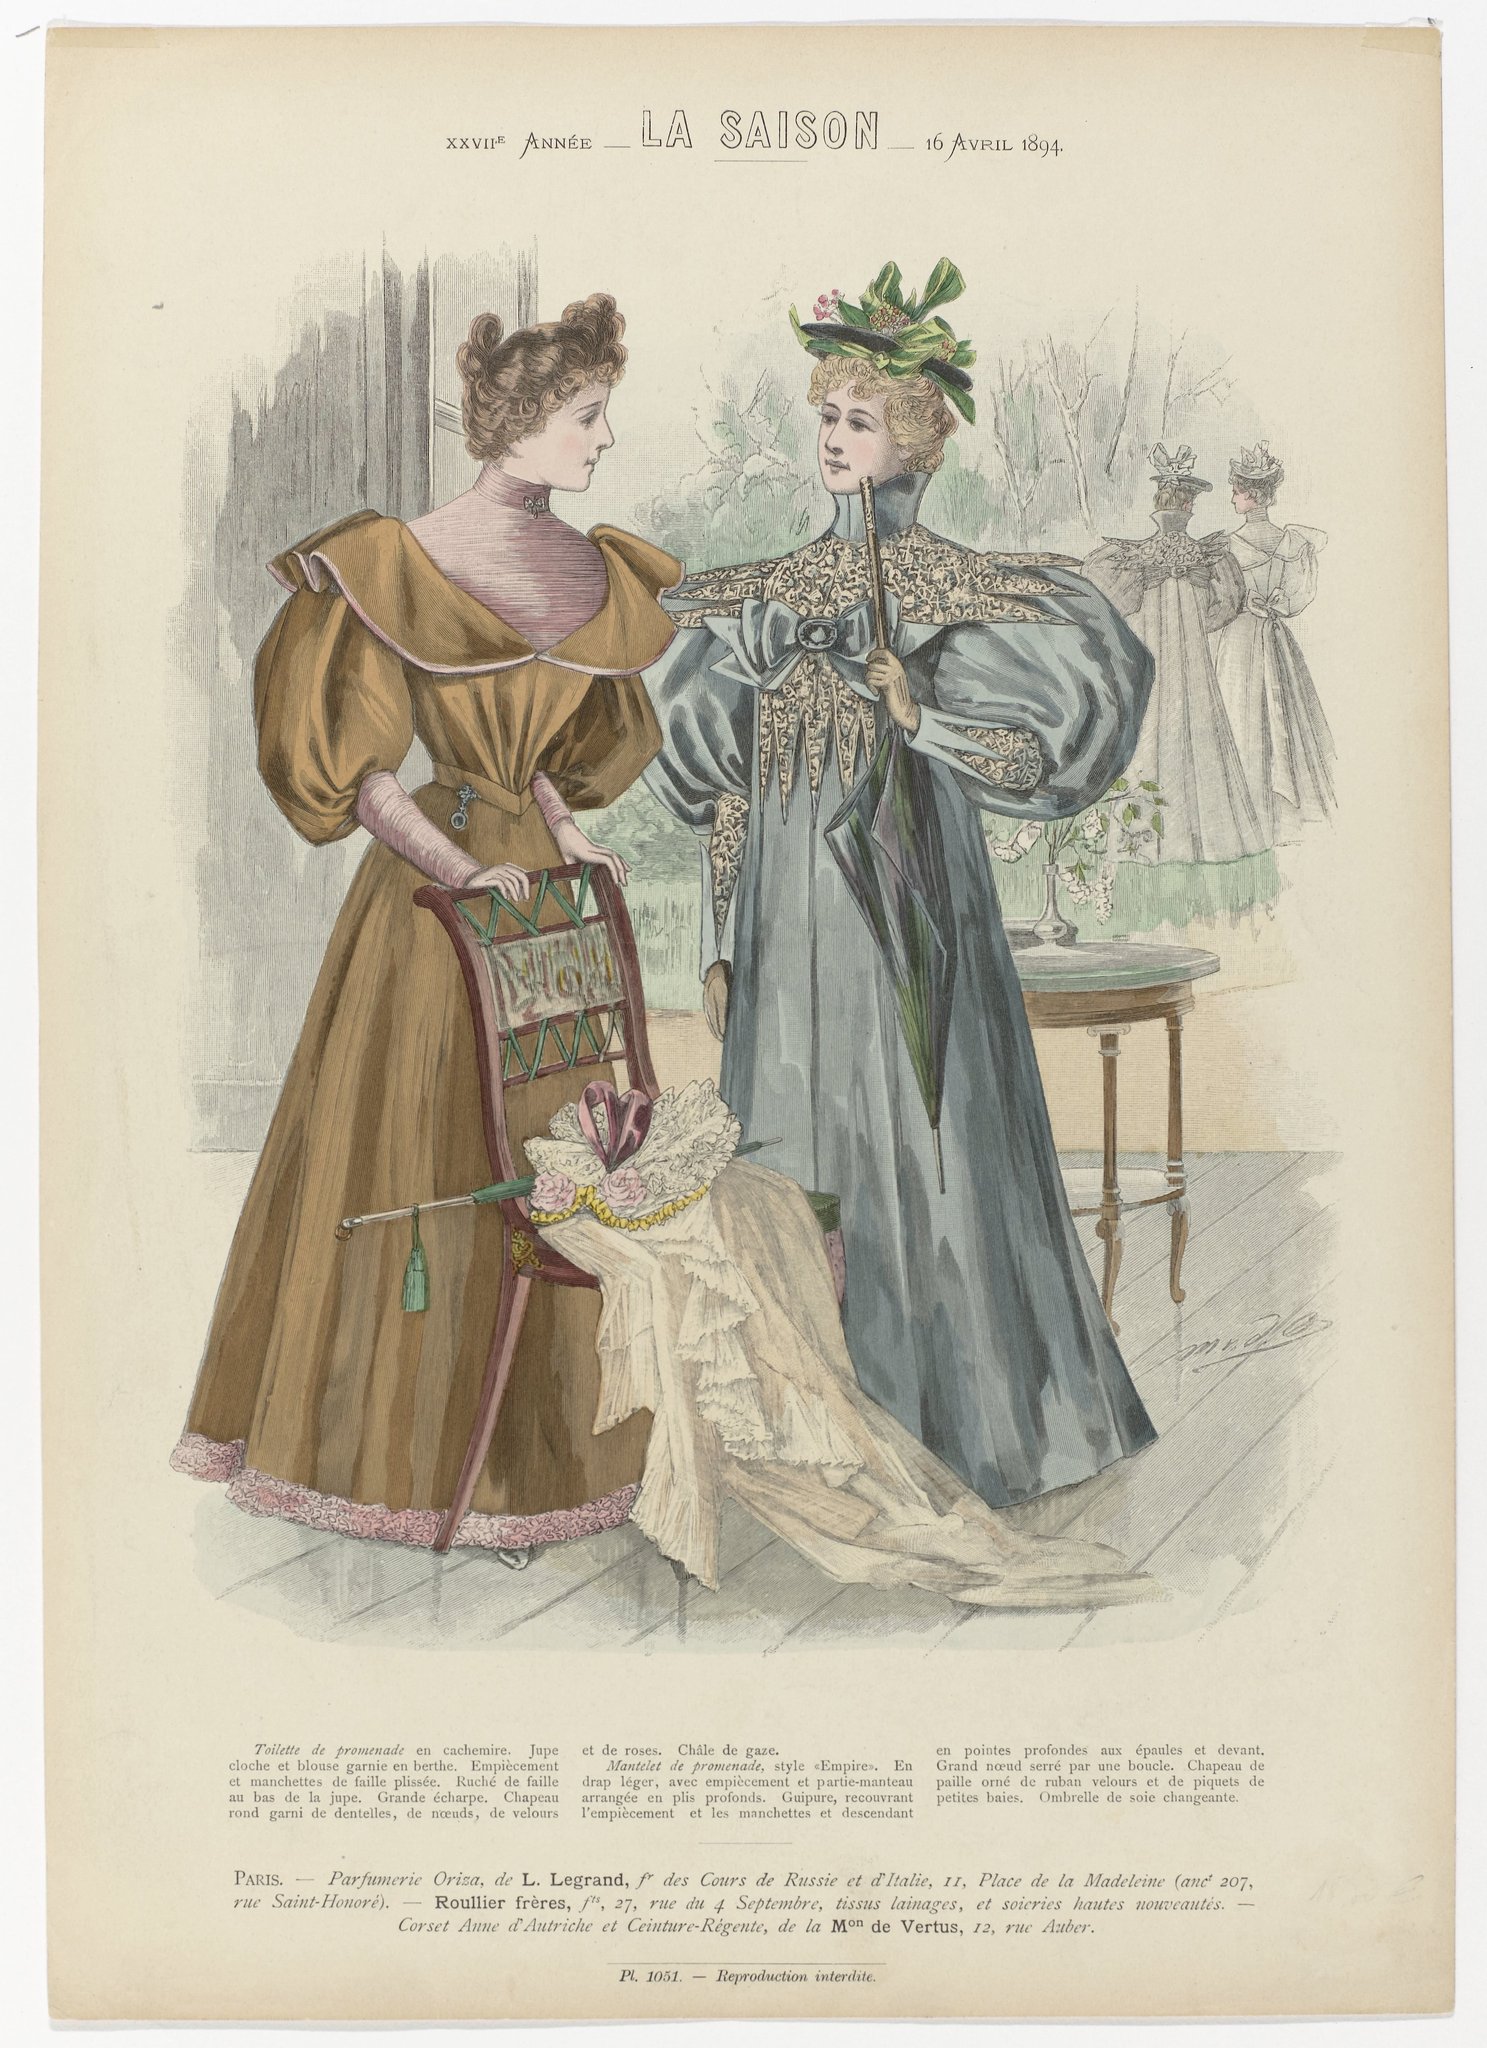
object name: fashion print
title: La Saison, 16 Avril 1894, Pl. 1051, 23e année : Toilette de promenad (...)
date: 1894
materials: paper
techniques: engraving, hand coloring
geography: paris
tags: bow (ornamental part of clothing) (+ women's clothes), border, ribbon, braid (+ women's clothes), clothing for the upper part of the body: blouse (+ women's clothes), neck-gear ~ clothing (bertha) (+ women's clothes), coat (+ women's clothes), head-gear (straw hat) (+ women's clothes), fashion plates, skirt (+ women's clothes), parasol, sunshade (+ women's clothes)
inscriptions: caption: ‘Toilette de promenade en cachemire. Jupe cloche et blouse garnie en berthe. Empiècement et manchettes de faille plissée. Ruché de faille au bas de la jupe. Grande écharpe. Chapeau rond garni de dentelles, de noeuds, de velours et de roses. Châle de gaze. Mantelet de promenade, style <Empire>. En drap léger, avec empiècement et partie-manteau arrangée en plis profonds. Guipure, recouvrant l'empiècement et les manchettes et descendant en pointes profondes au épaules et devant. Grand noeud serré par une boucle. Chapeau de paille orné de ruban velours et de piquets de petites baies. Ombrelle de soie changeante.’, caption: ‘PARIS. - Parfumerie Oriza, de L. Legrand, fr des Cours de Russie et d'Italie, 11, place de la madeleine (anct 207, rue Saint-Honoré). - Roullier drères, fts, 27, rue du 4 Septembre, tissus lainages, et soieries hautes nouveautés. - Corset Anne d'Autriche et Ceinture-Régente, de la M.on de Vertus, 12, rue Auber.’, title: ‘XXVIIE ANNÉE / La Saison / 16 AVRIL 1894.’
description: Vrouw in een wandelkostuum van kasjemier. Uitlopende rok en blouse versierd met berthe. Op de stoel ligt een ronde hoed versierd met kant, strikken, fluweel en rozen. Sjaal van tule. Andere vrouw in een 'mantelet' of jas om mee te wandelen in de 'Empire' stijl. Middenvoor een grote strik met gesp. Op het hoofd een strohoed versierd met fluweel lint. Parasol van changeantzijde. Op de achtergrond twee dezelfde figuren, op de rug gezien. Onder de voorstelling enkele regels reclametekst voor verschillende producten. Prent uit het modetijdschrift La Saison (1867-1902).